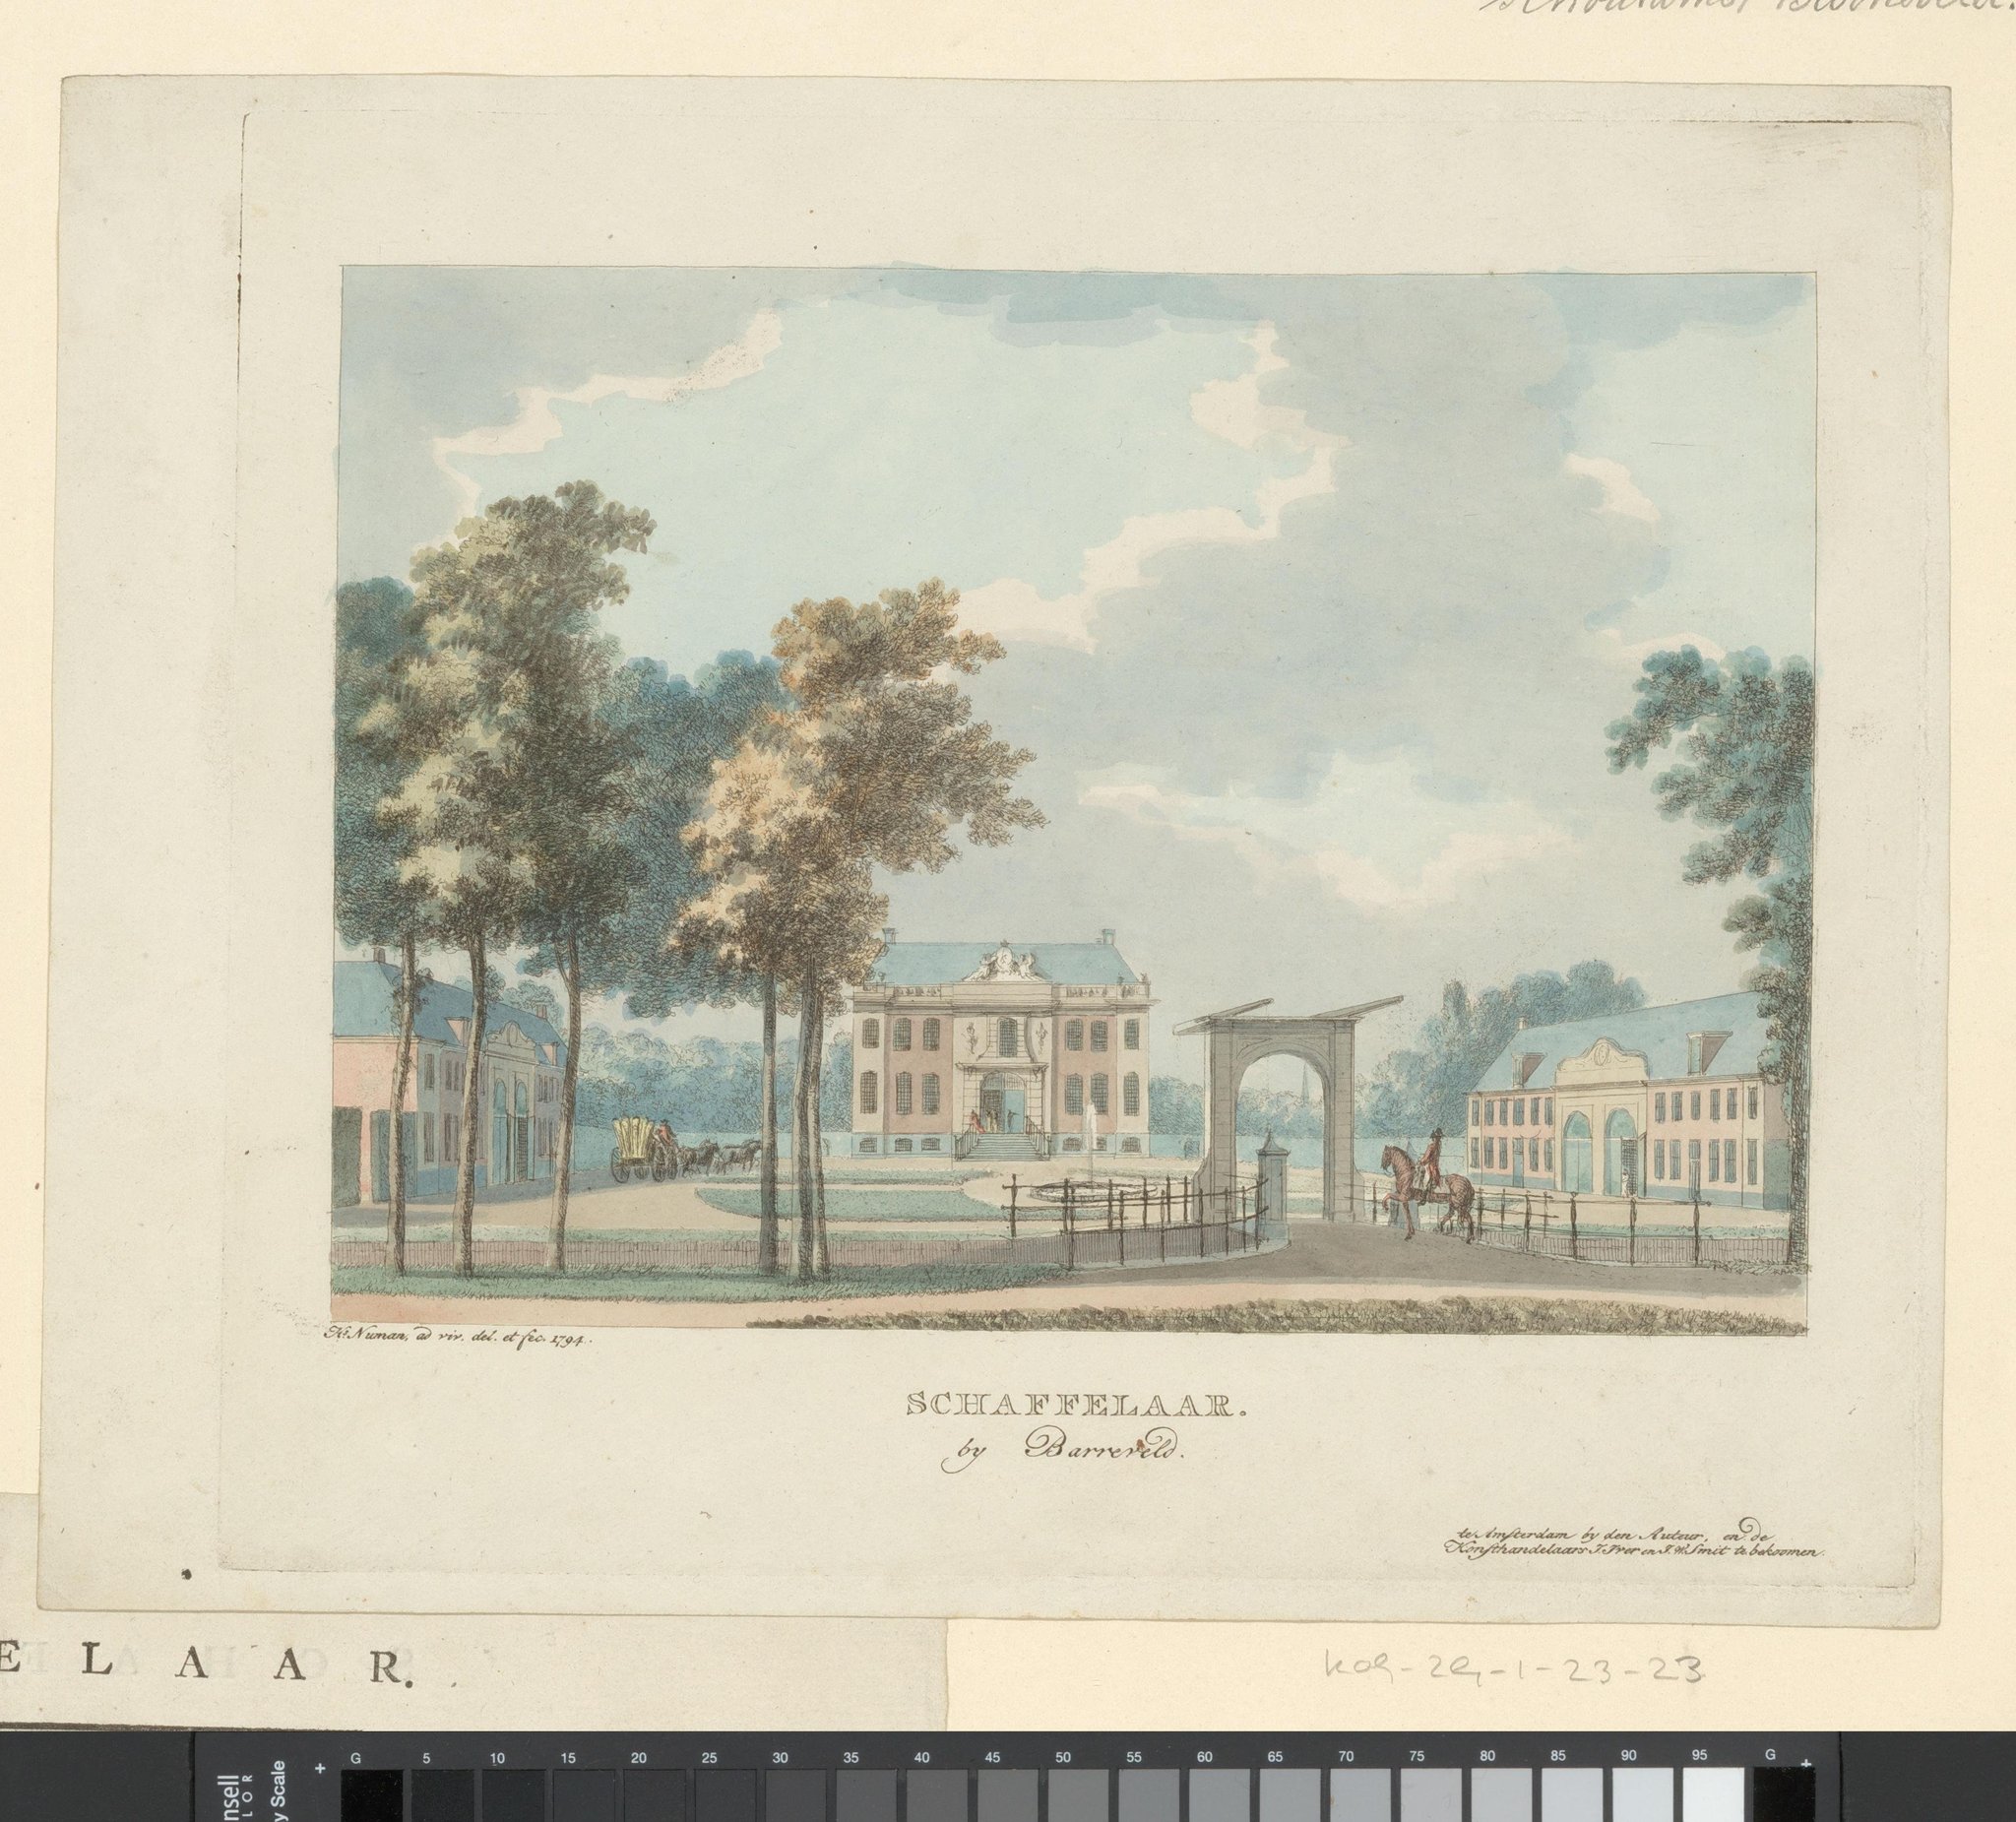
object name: print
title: Gezicht op Kasteel de Schaffelaar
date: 1794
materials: paper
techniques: engraving, etching, hand coloring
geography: amsterdam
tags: country-house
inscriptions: stamp, stamp, collector's mark: Lugt 1641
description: Prent gebruikt in: Numan, Hermanus. Vierentwintig printtekeningen met couleuren, verbeeldende Hollandsche buitenplaatzen. Amsterdam: Jan IJver, Jan Willem Smit en Hermanus Numan, 1797.